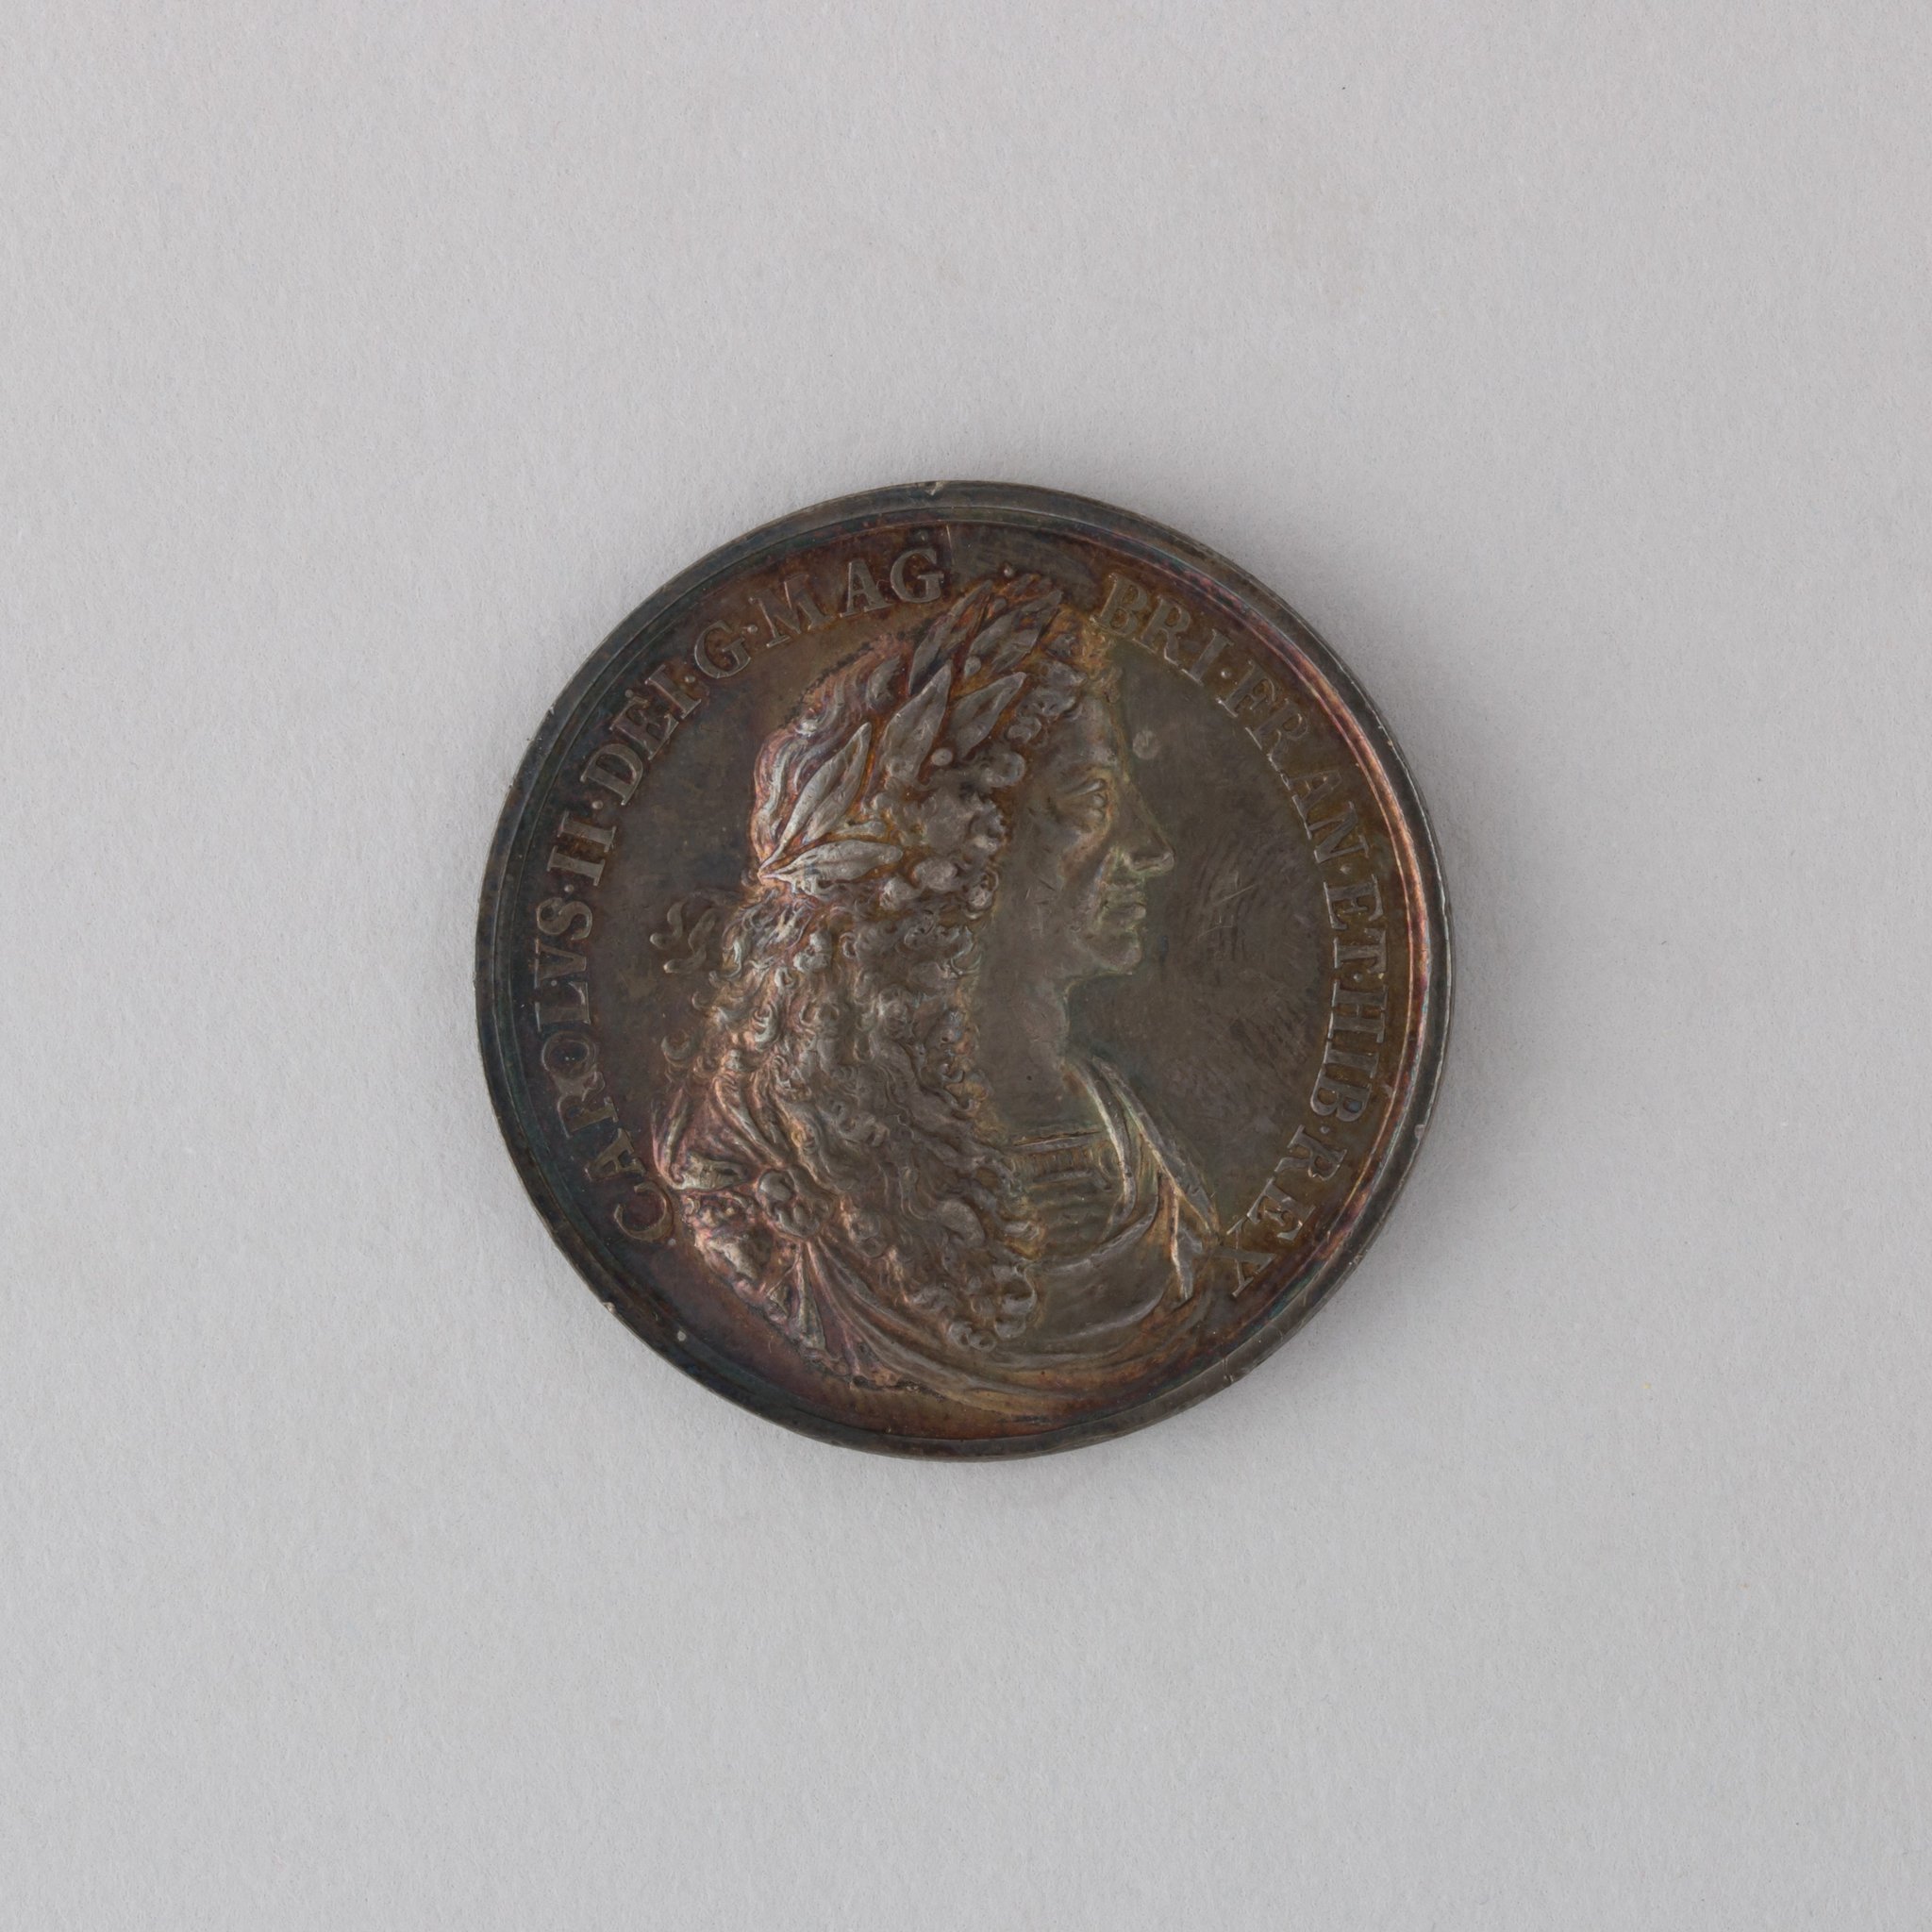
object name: medal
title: Medal Showing Charles II and Catherine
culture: british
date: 1662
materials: silver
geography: england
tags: men,women